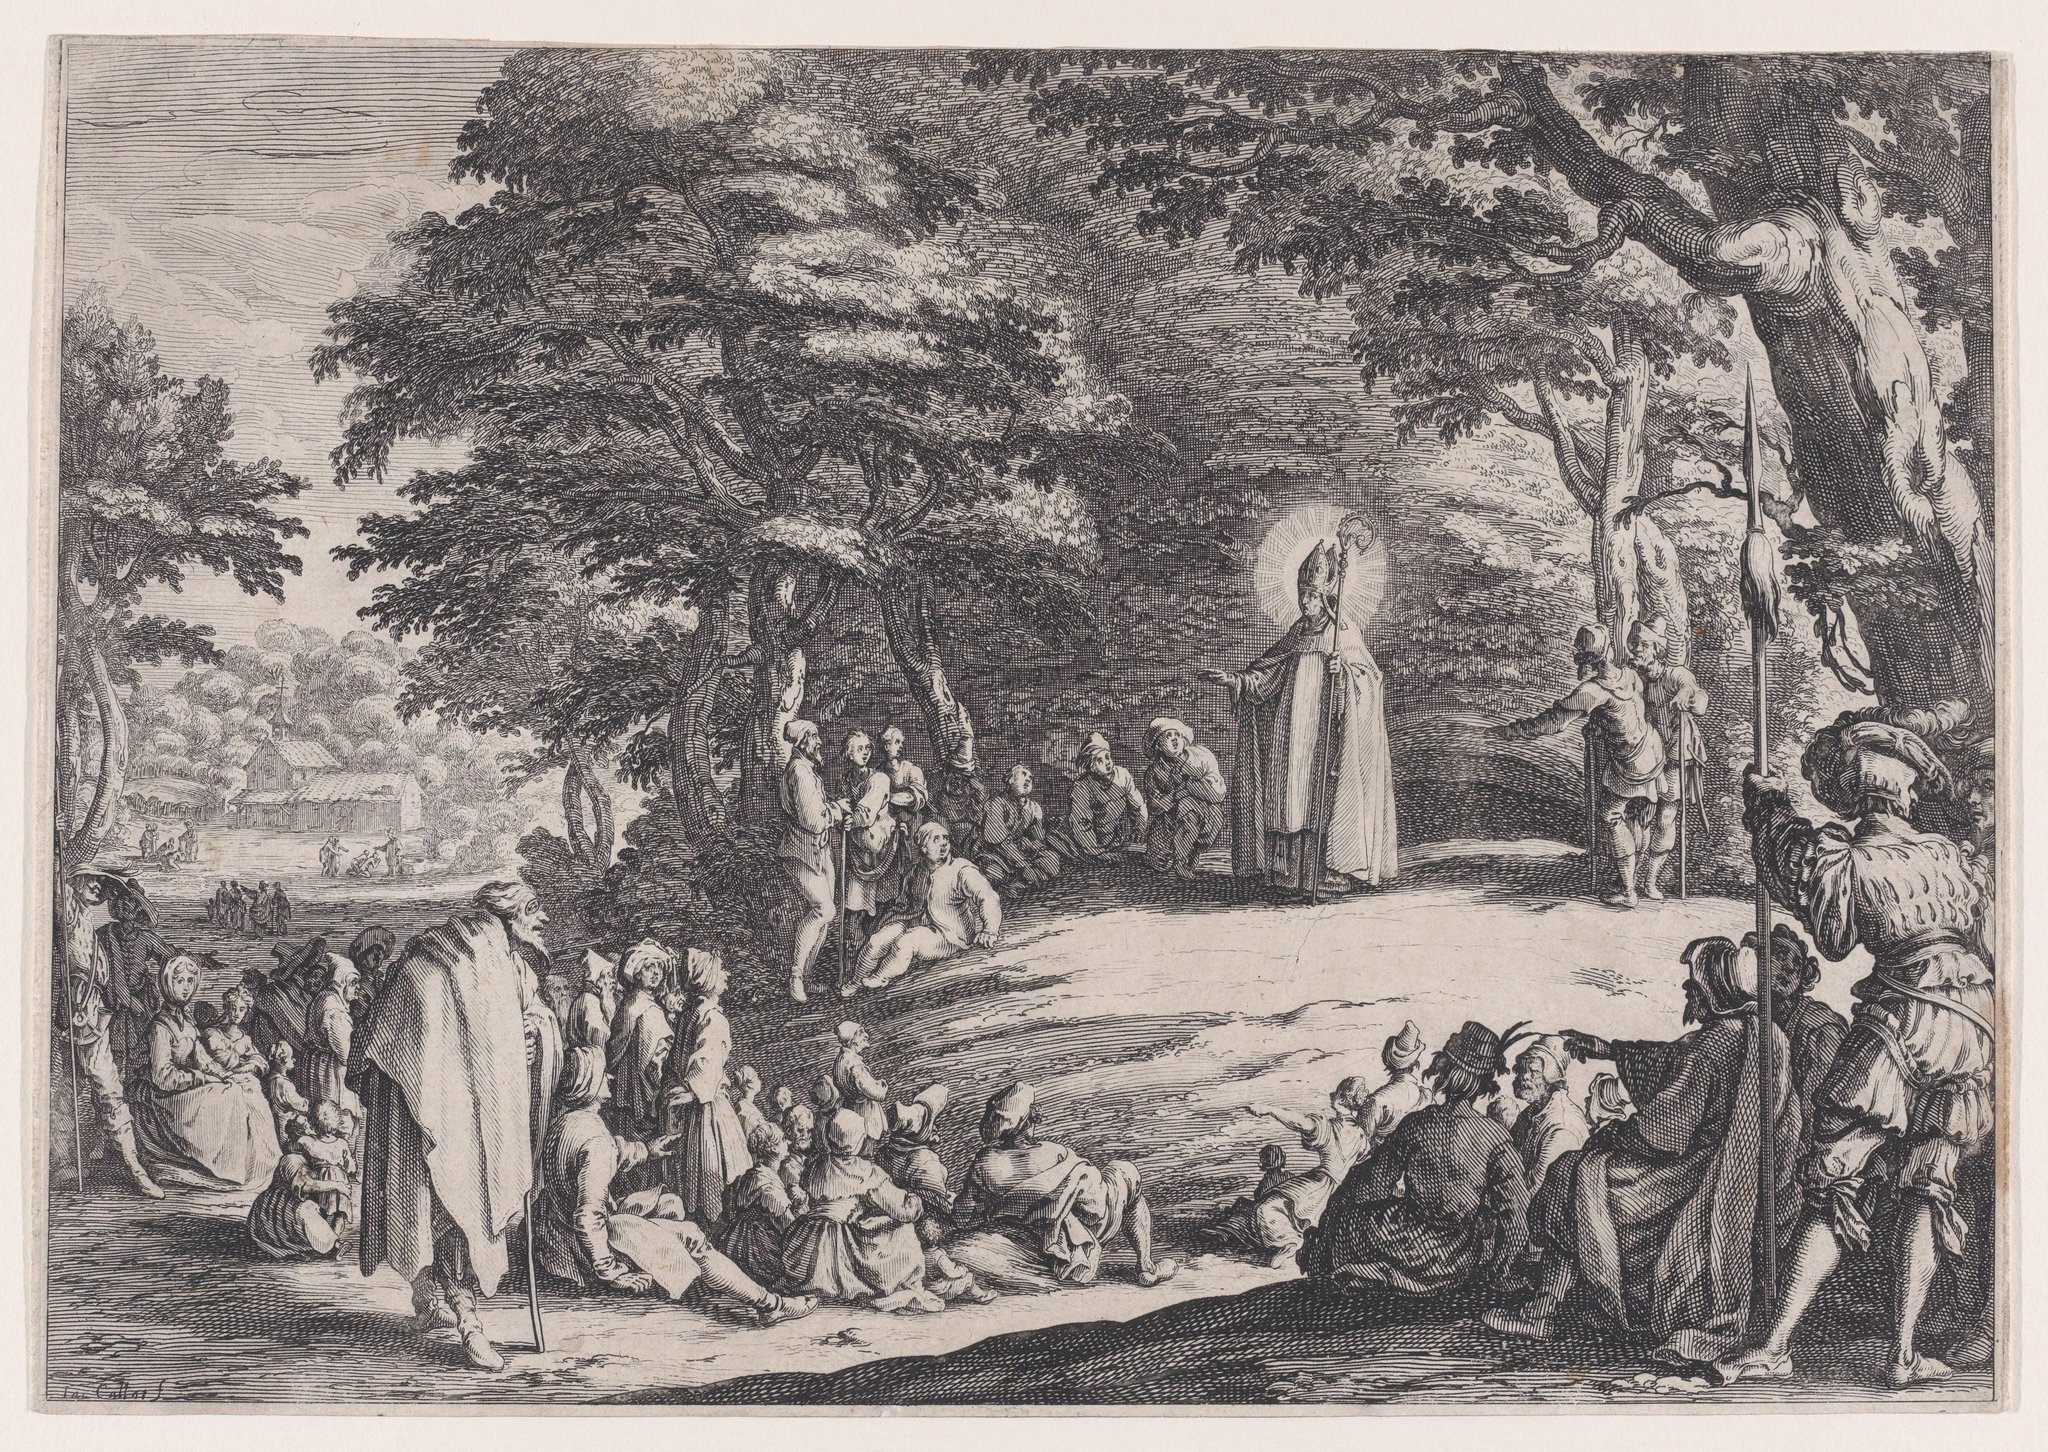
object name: print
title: Saint Amond, St. Nicholas, or St. Séverin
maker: jacques callot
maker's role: artist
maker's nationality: french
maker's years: 1592-1635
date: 1625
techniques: engraving, etching